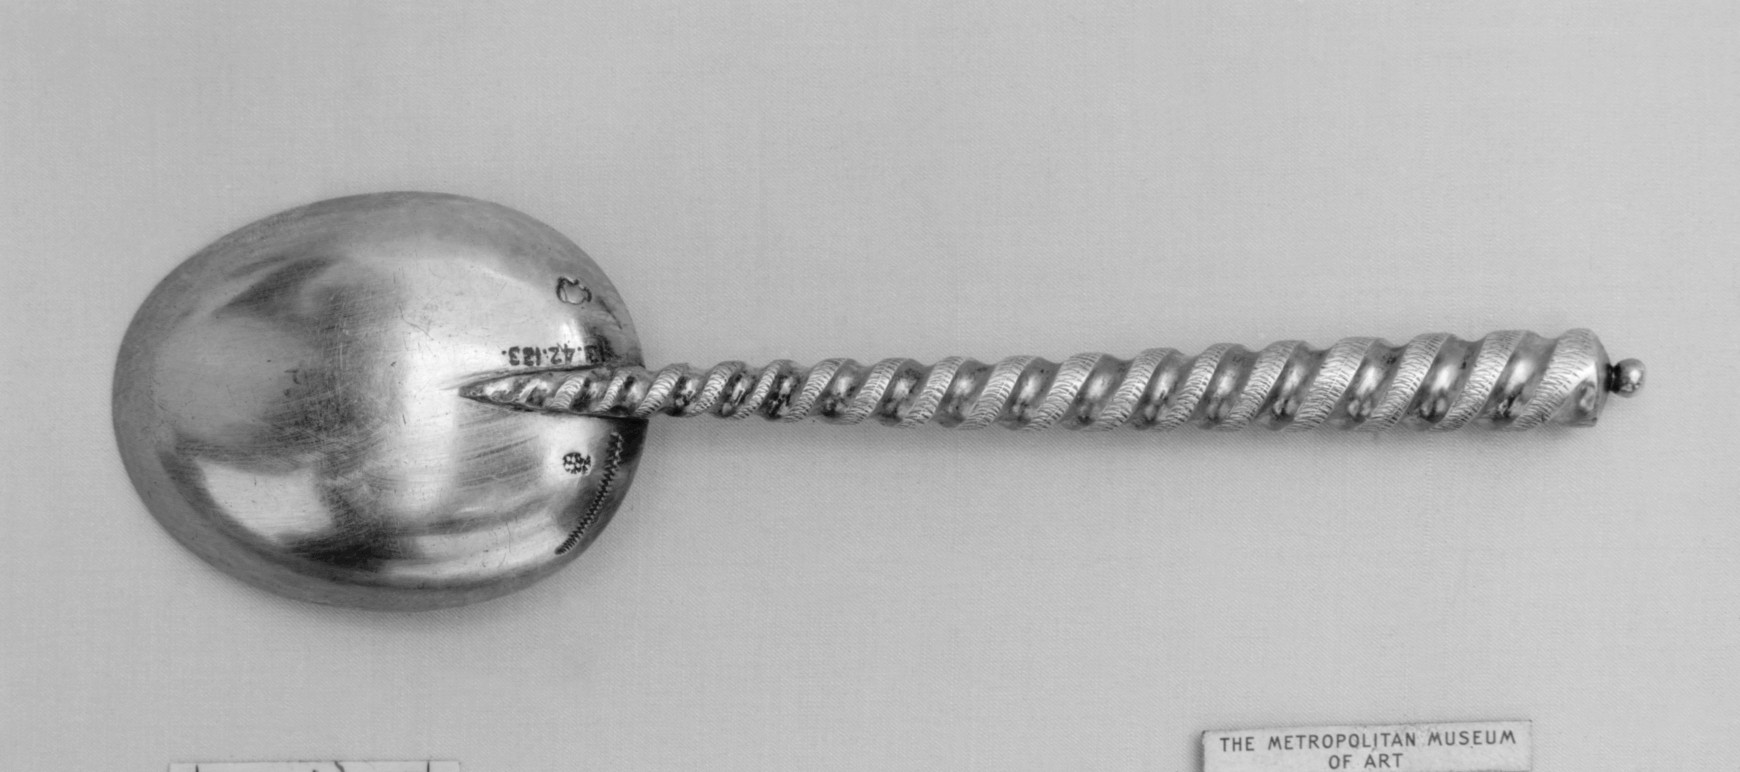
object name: spoon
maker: michael hafner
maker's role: maker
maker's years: 1665-1700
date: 1674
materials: silver gilt